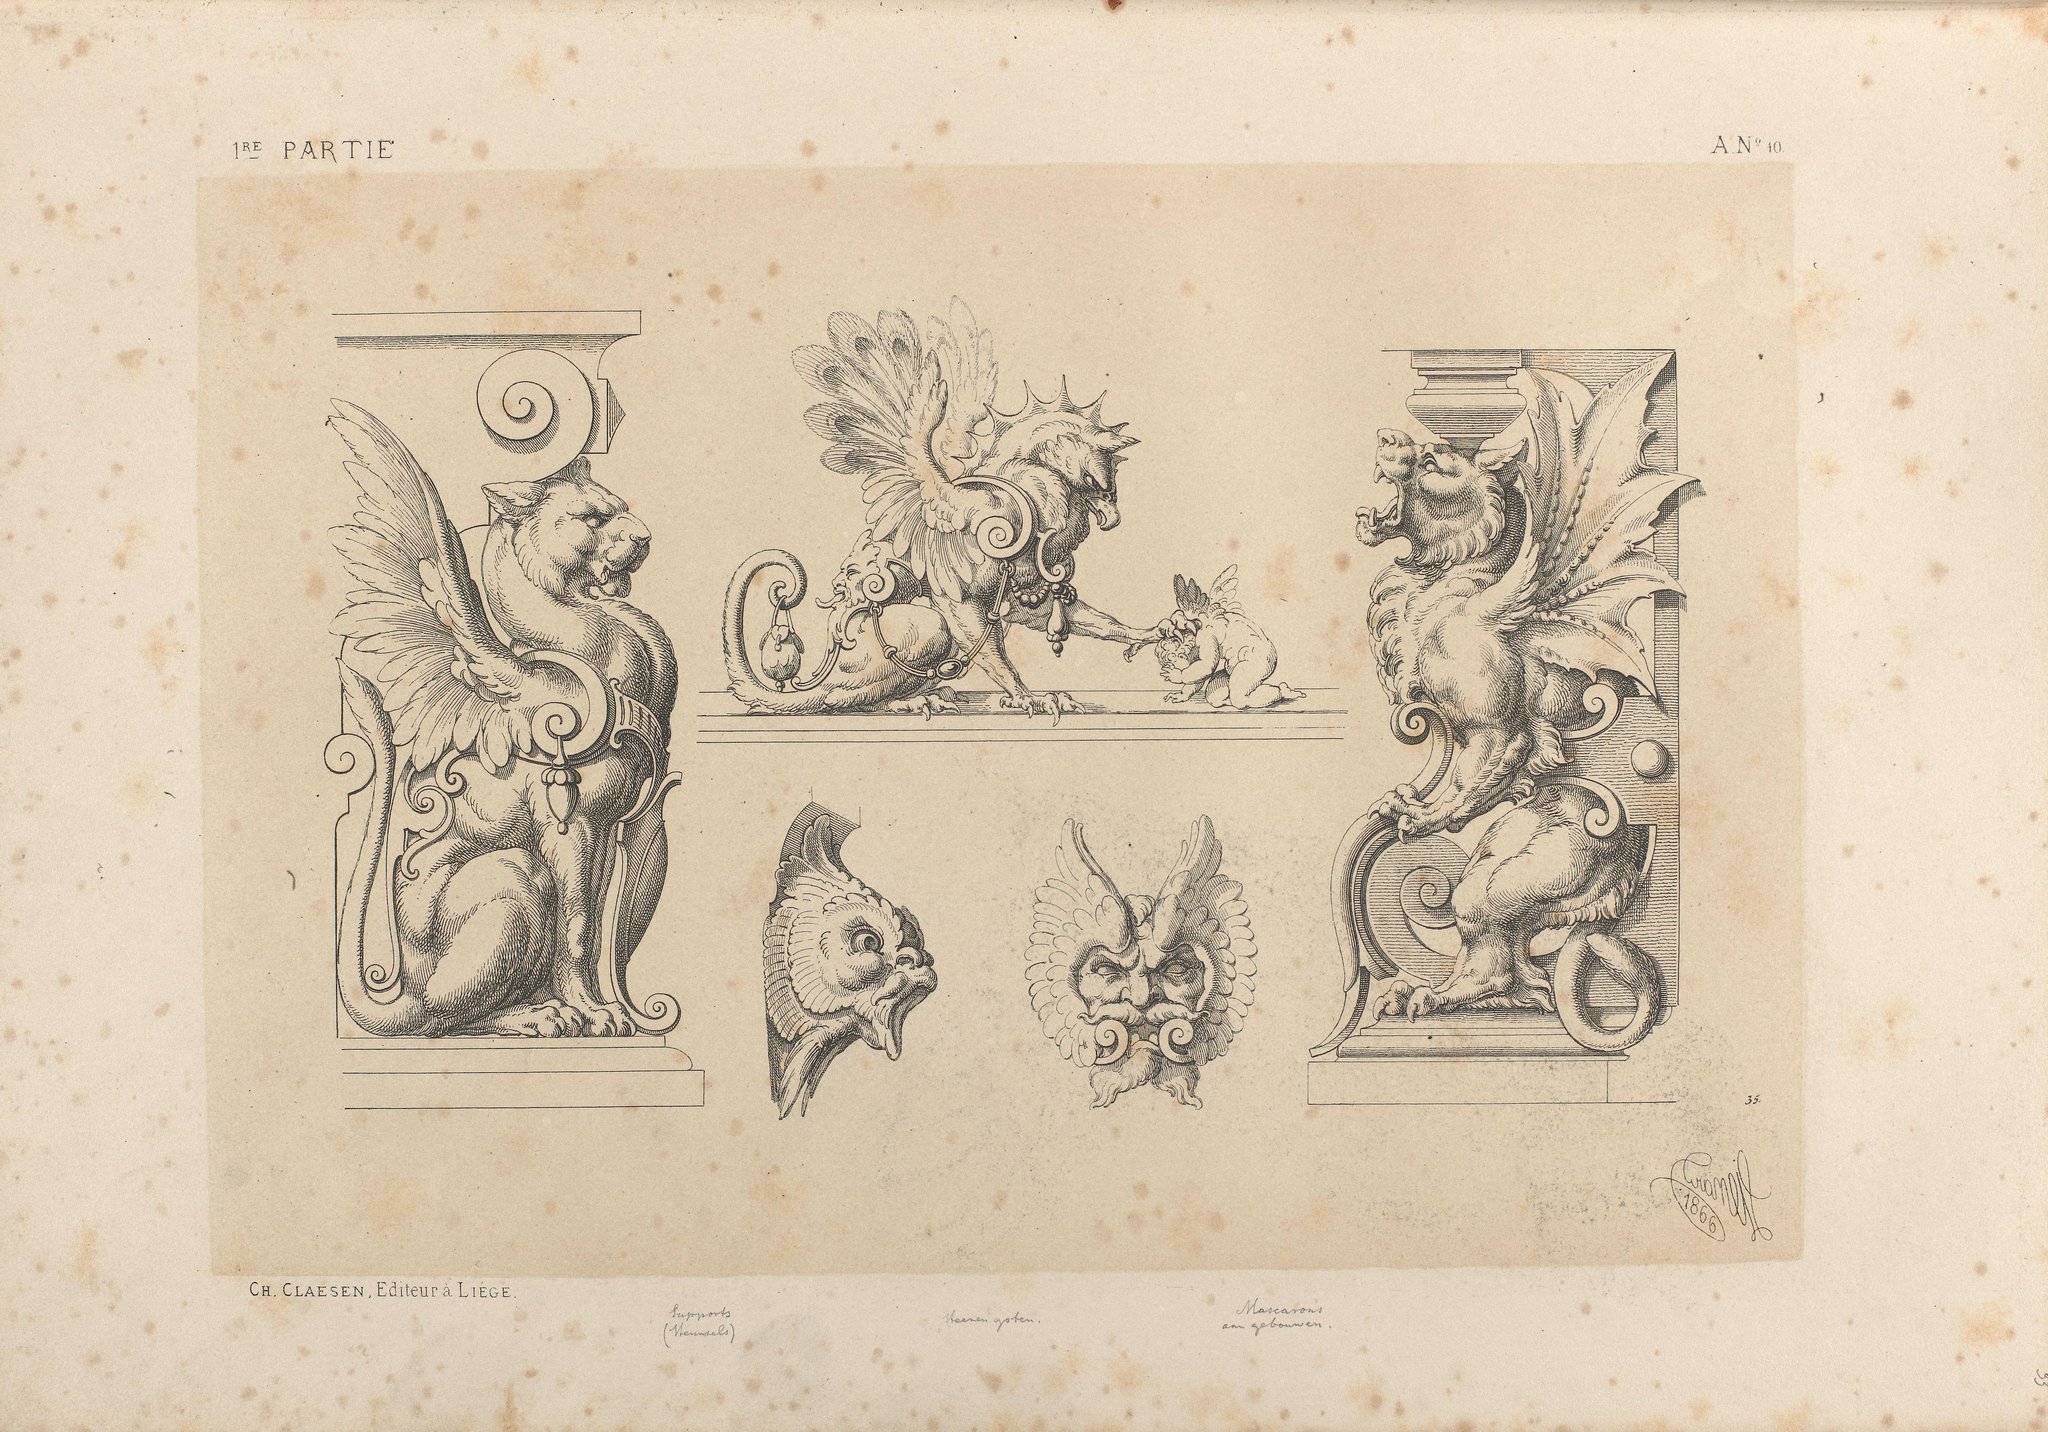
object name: print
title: Vijf ornamenten voor gebouwen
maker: michel liénard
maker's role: print maker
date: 1866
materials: paper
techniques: tone lithography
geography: liège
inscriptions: annotation: ‘Supports (Steunsels) / Steenen goten. / Mascarons aan gebouwen.’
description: Midden onder staan twee mascarons afgebeeld. Linksboven: 1re partie, rechtsboven: A. N° 10., rechtsonder: 35.